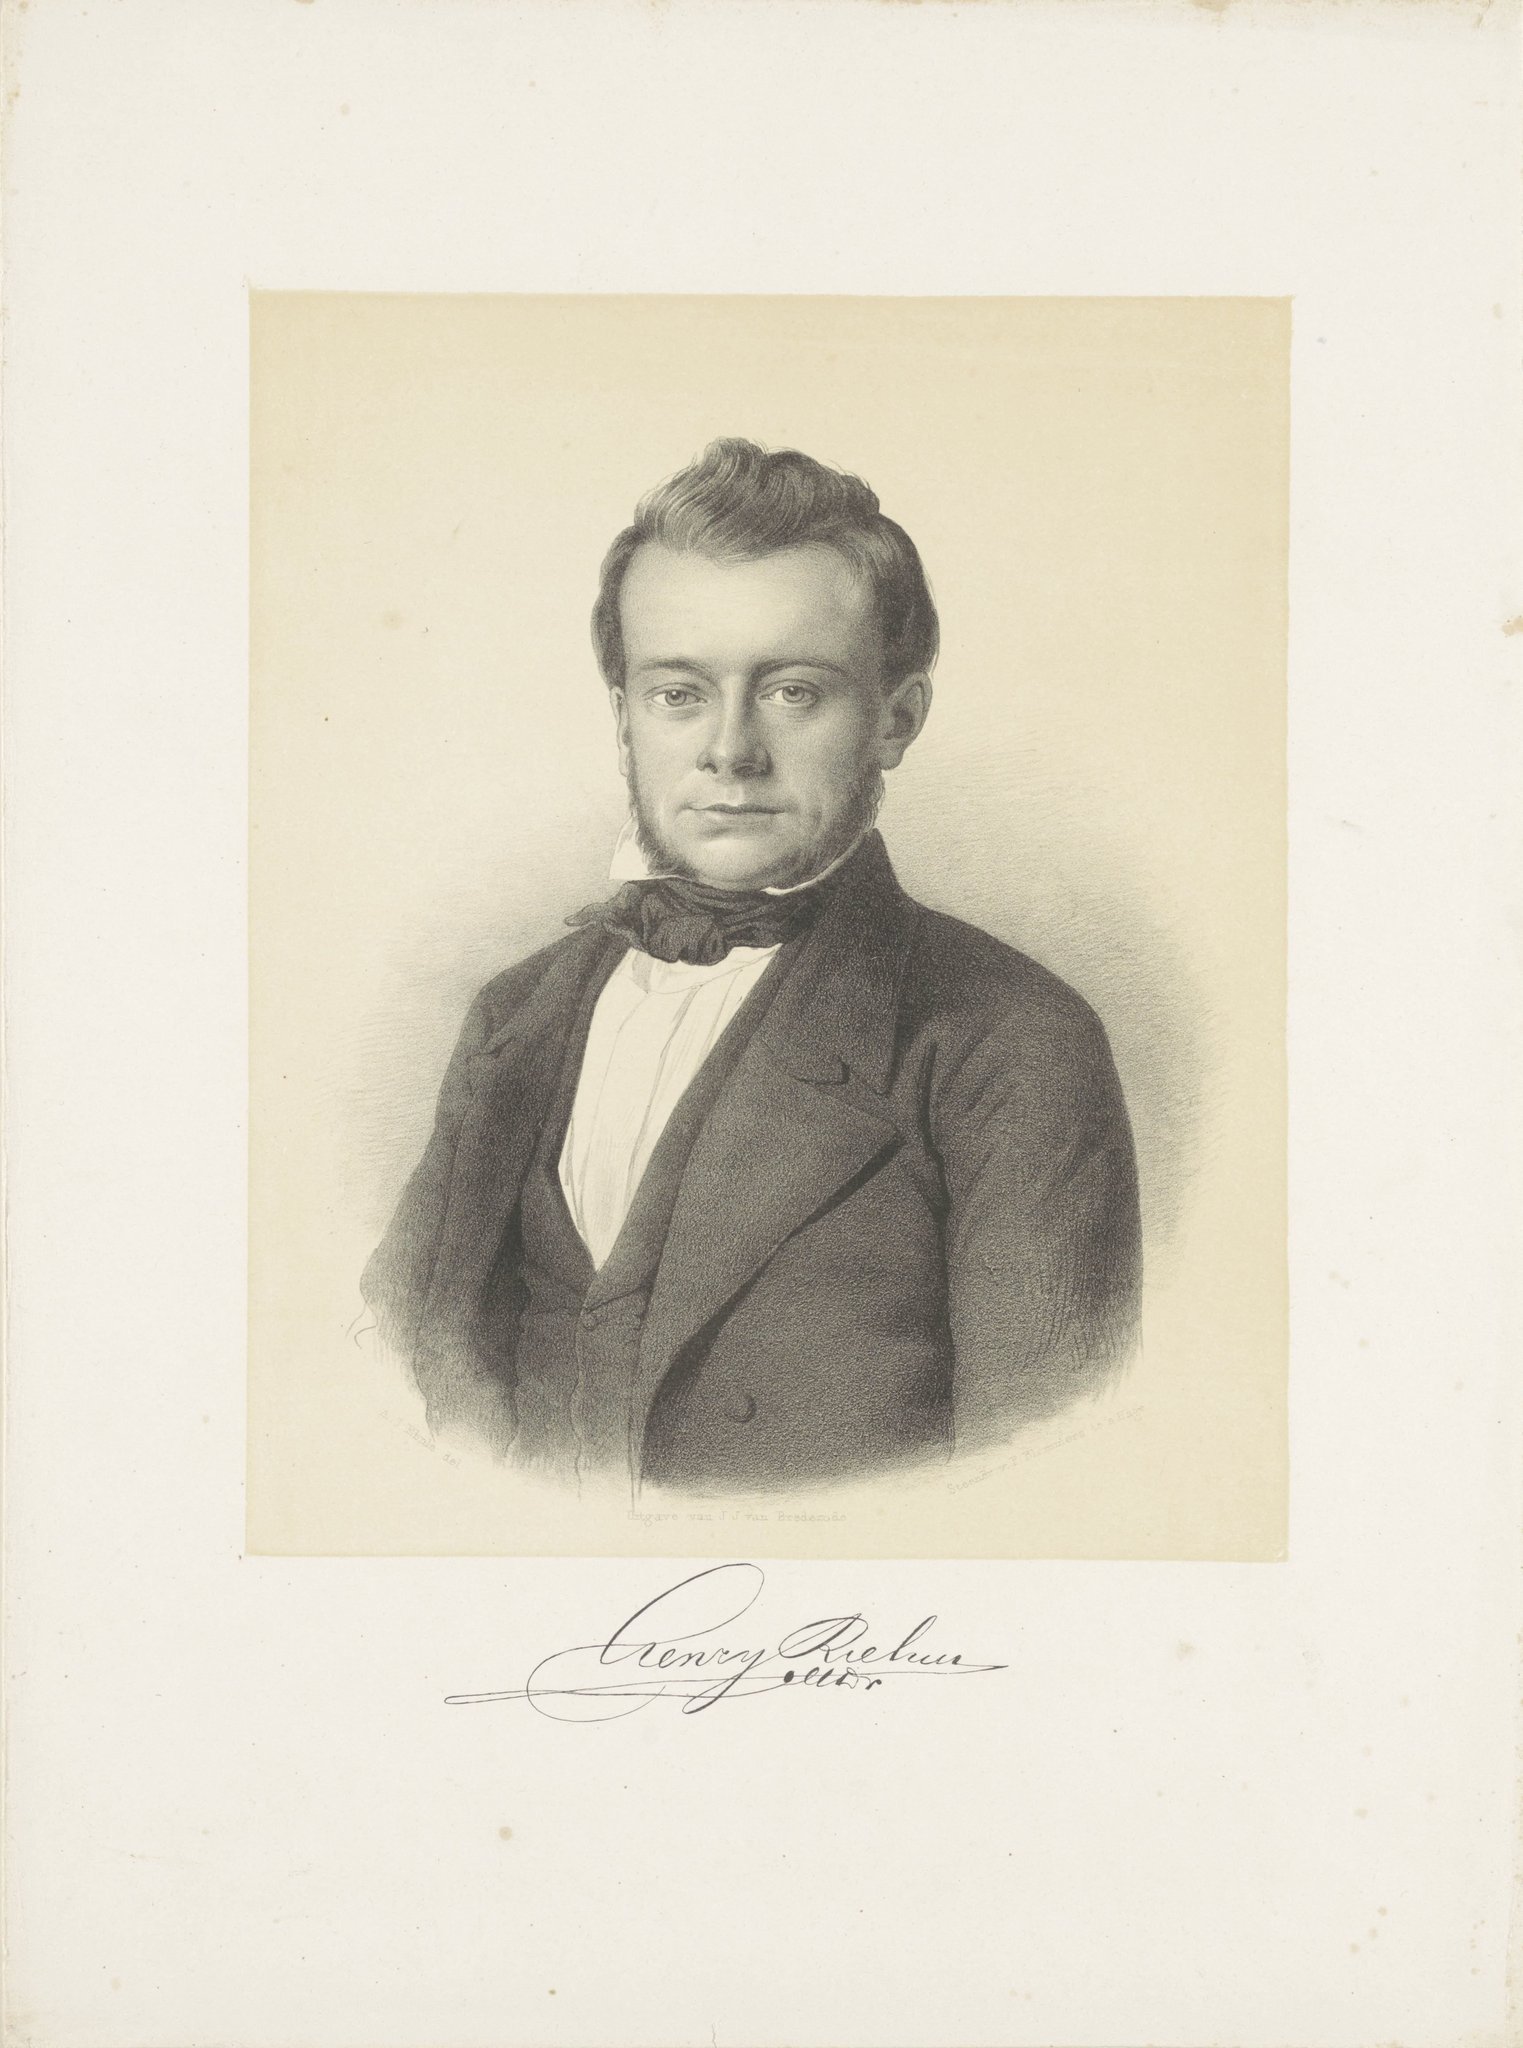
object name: print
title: Portret van Christian Heinrich Riehm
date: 1847-1883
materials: paper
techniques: tone lithography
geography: the hague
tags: amsterdam, draughtsman, historical persons (+ (full) bust portrait)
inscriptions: collector's mark: Lugt 2228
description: Onder het portret de signatuur van de geportretteerde.